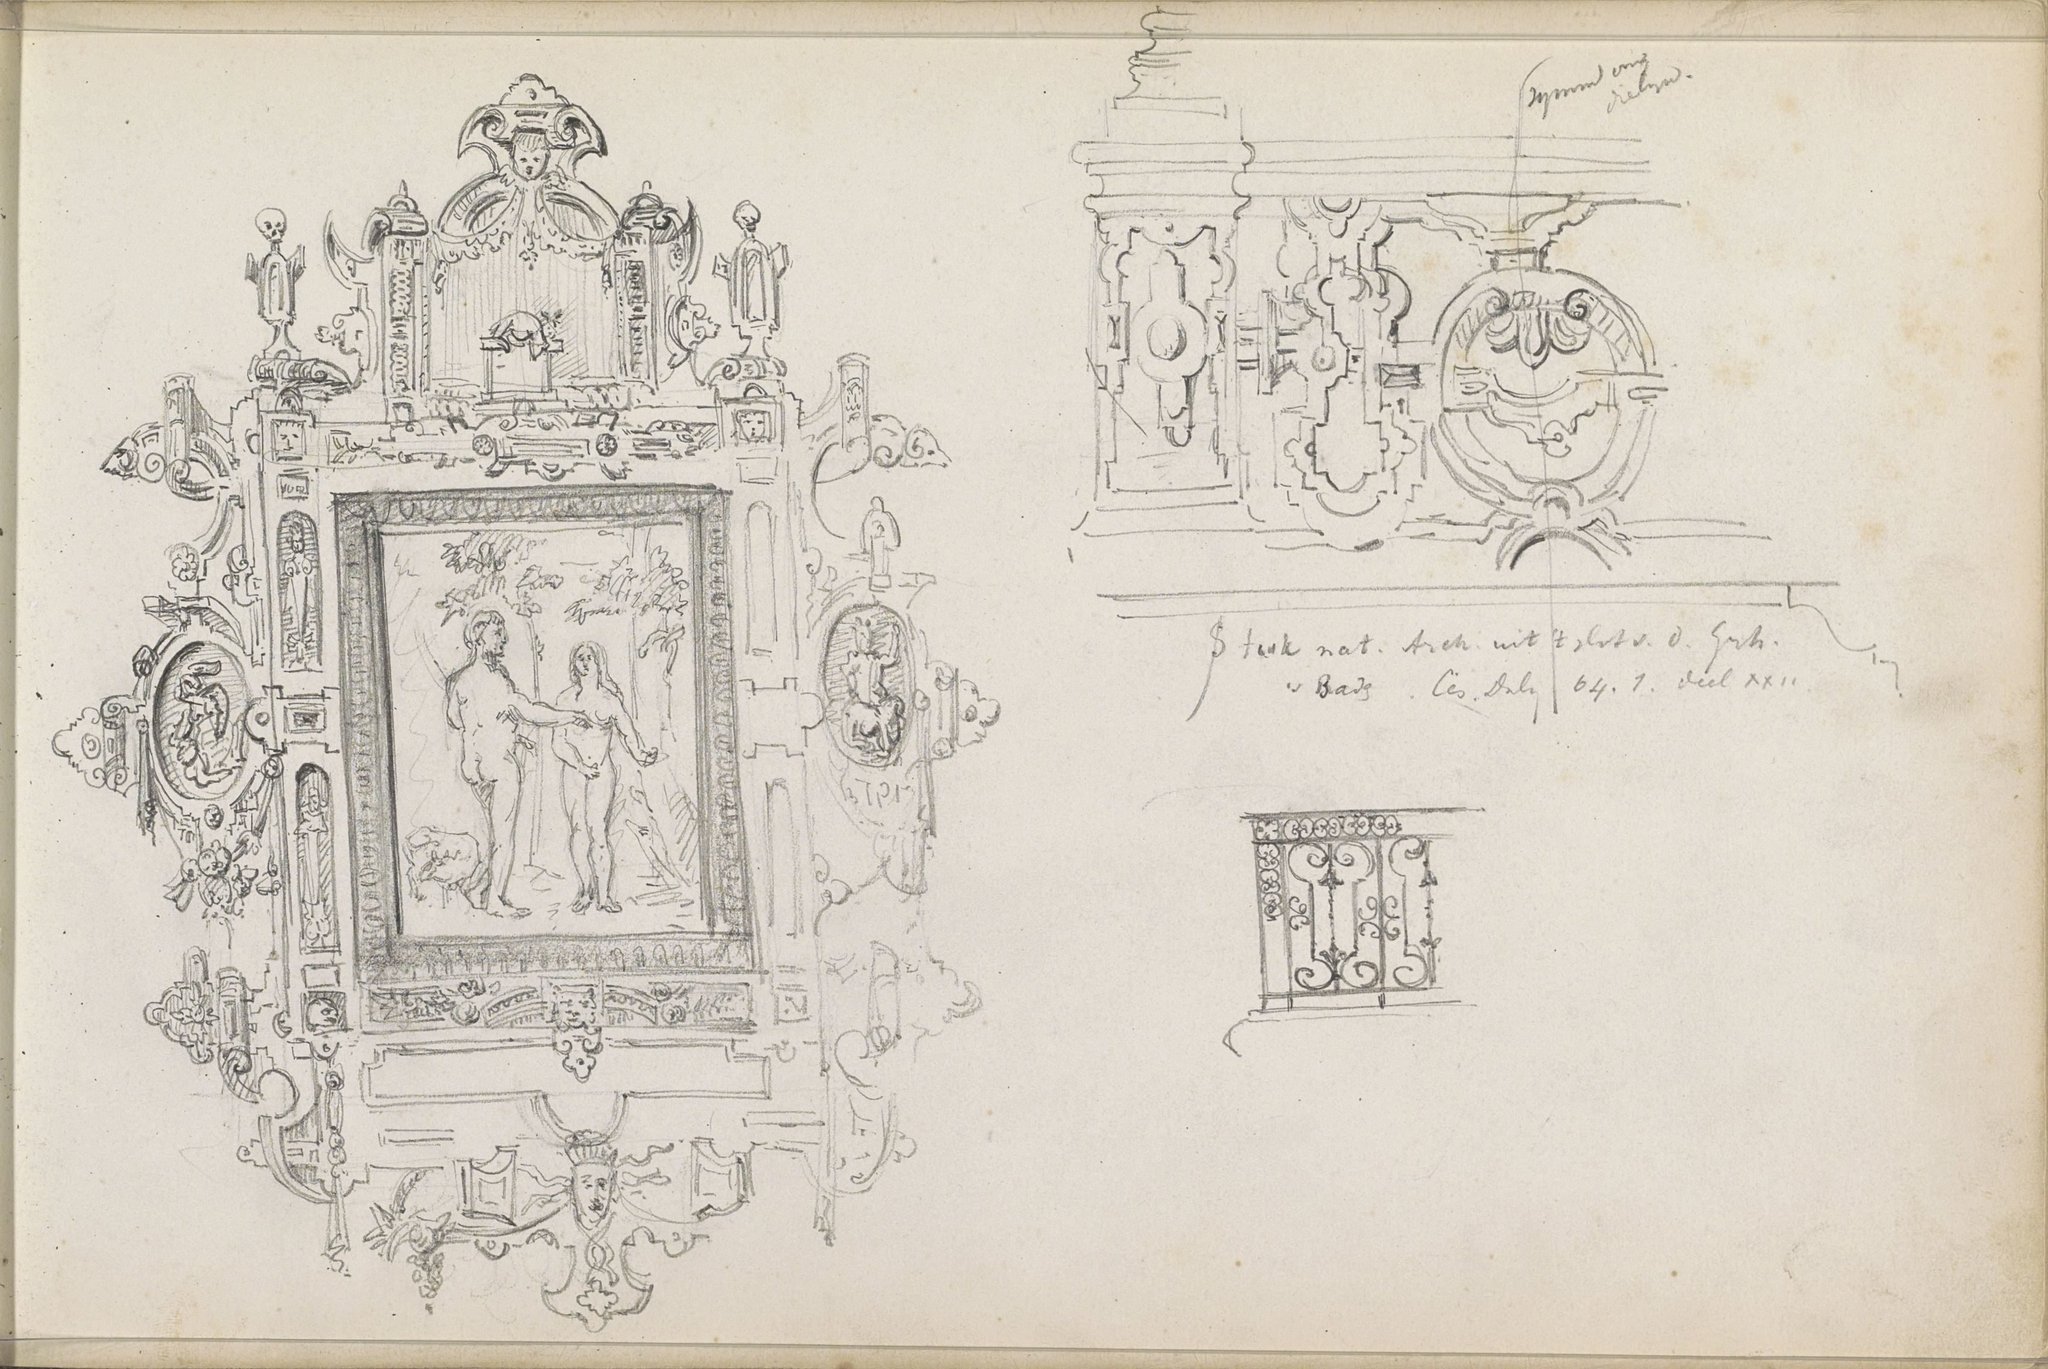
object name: sketchbook leaf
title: Voorstelling van Adam en Eva in ornamentele omlijsting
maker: isaac gosschalk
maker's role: draughtsman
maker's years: 1838-1907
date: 1862-1867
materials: paper, pencil, watercolor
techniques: brush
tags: picture, painting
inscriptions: annotation: ‘[...] Stuk nat. Arch. uit 't slot v.d. Grh/ v Ba[...] les Da[...] 64.1 deel xxii’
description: Blad 25 recto uit een schetsboek met 58 bladen.